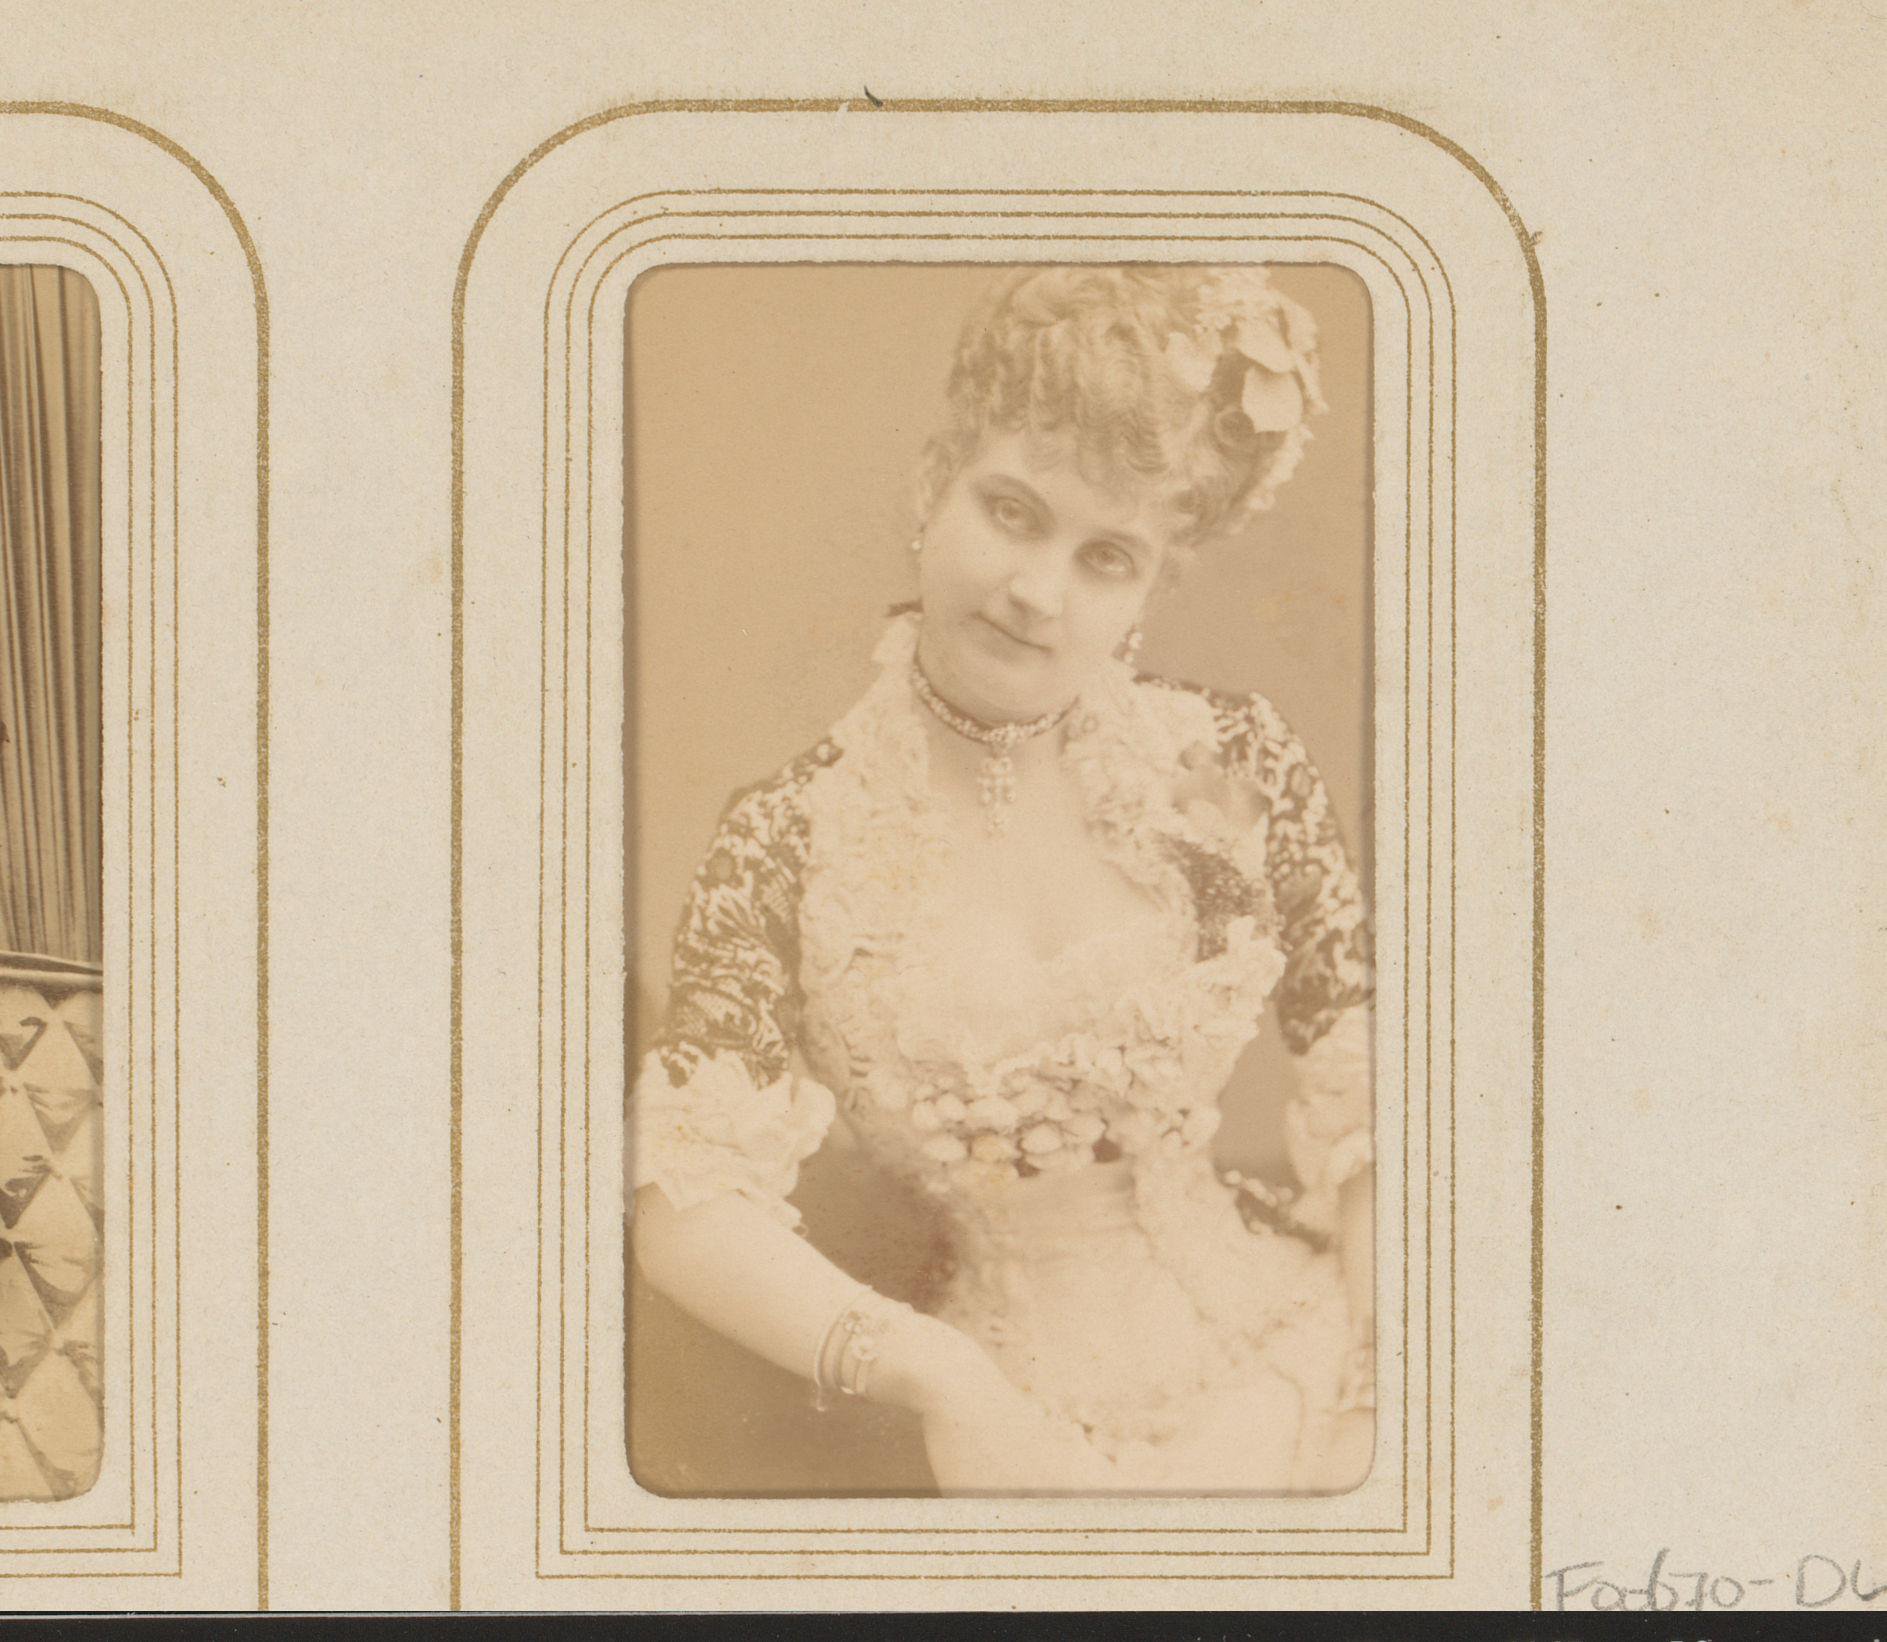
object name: photograph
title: Portret van een vrouw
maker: félix nadar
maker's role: ballonvaarder, fotograaf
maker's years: 1820-1910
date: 1880-1900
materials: cardboard, photographic support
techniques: albumen print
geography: paris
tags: historical persons - bb - woman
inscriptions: inscription: ‘Nadar/ Rue d'Anjou St. Honoré, 51/ Paris (...)’, annotation: ‘Faidre/ P.R,/ 20-’, annotation: ‘Faidre (Nadar)’